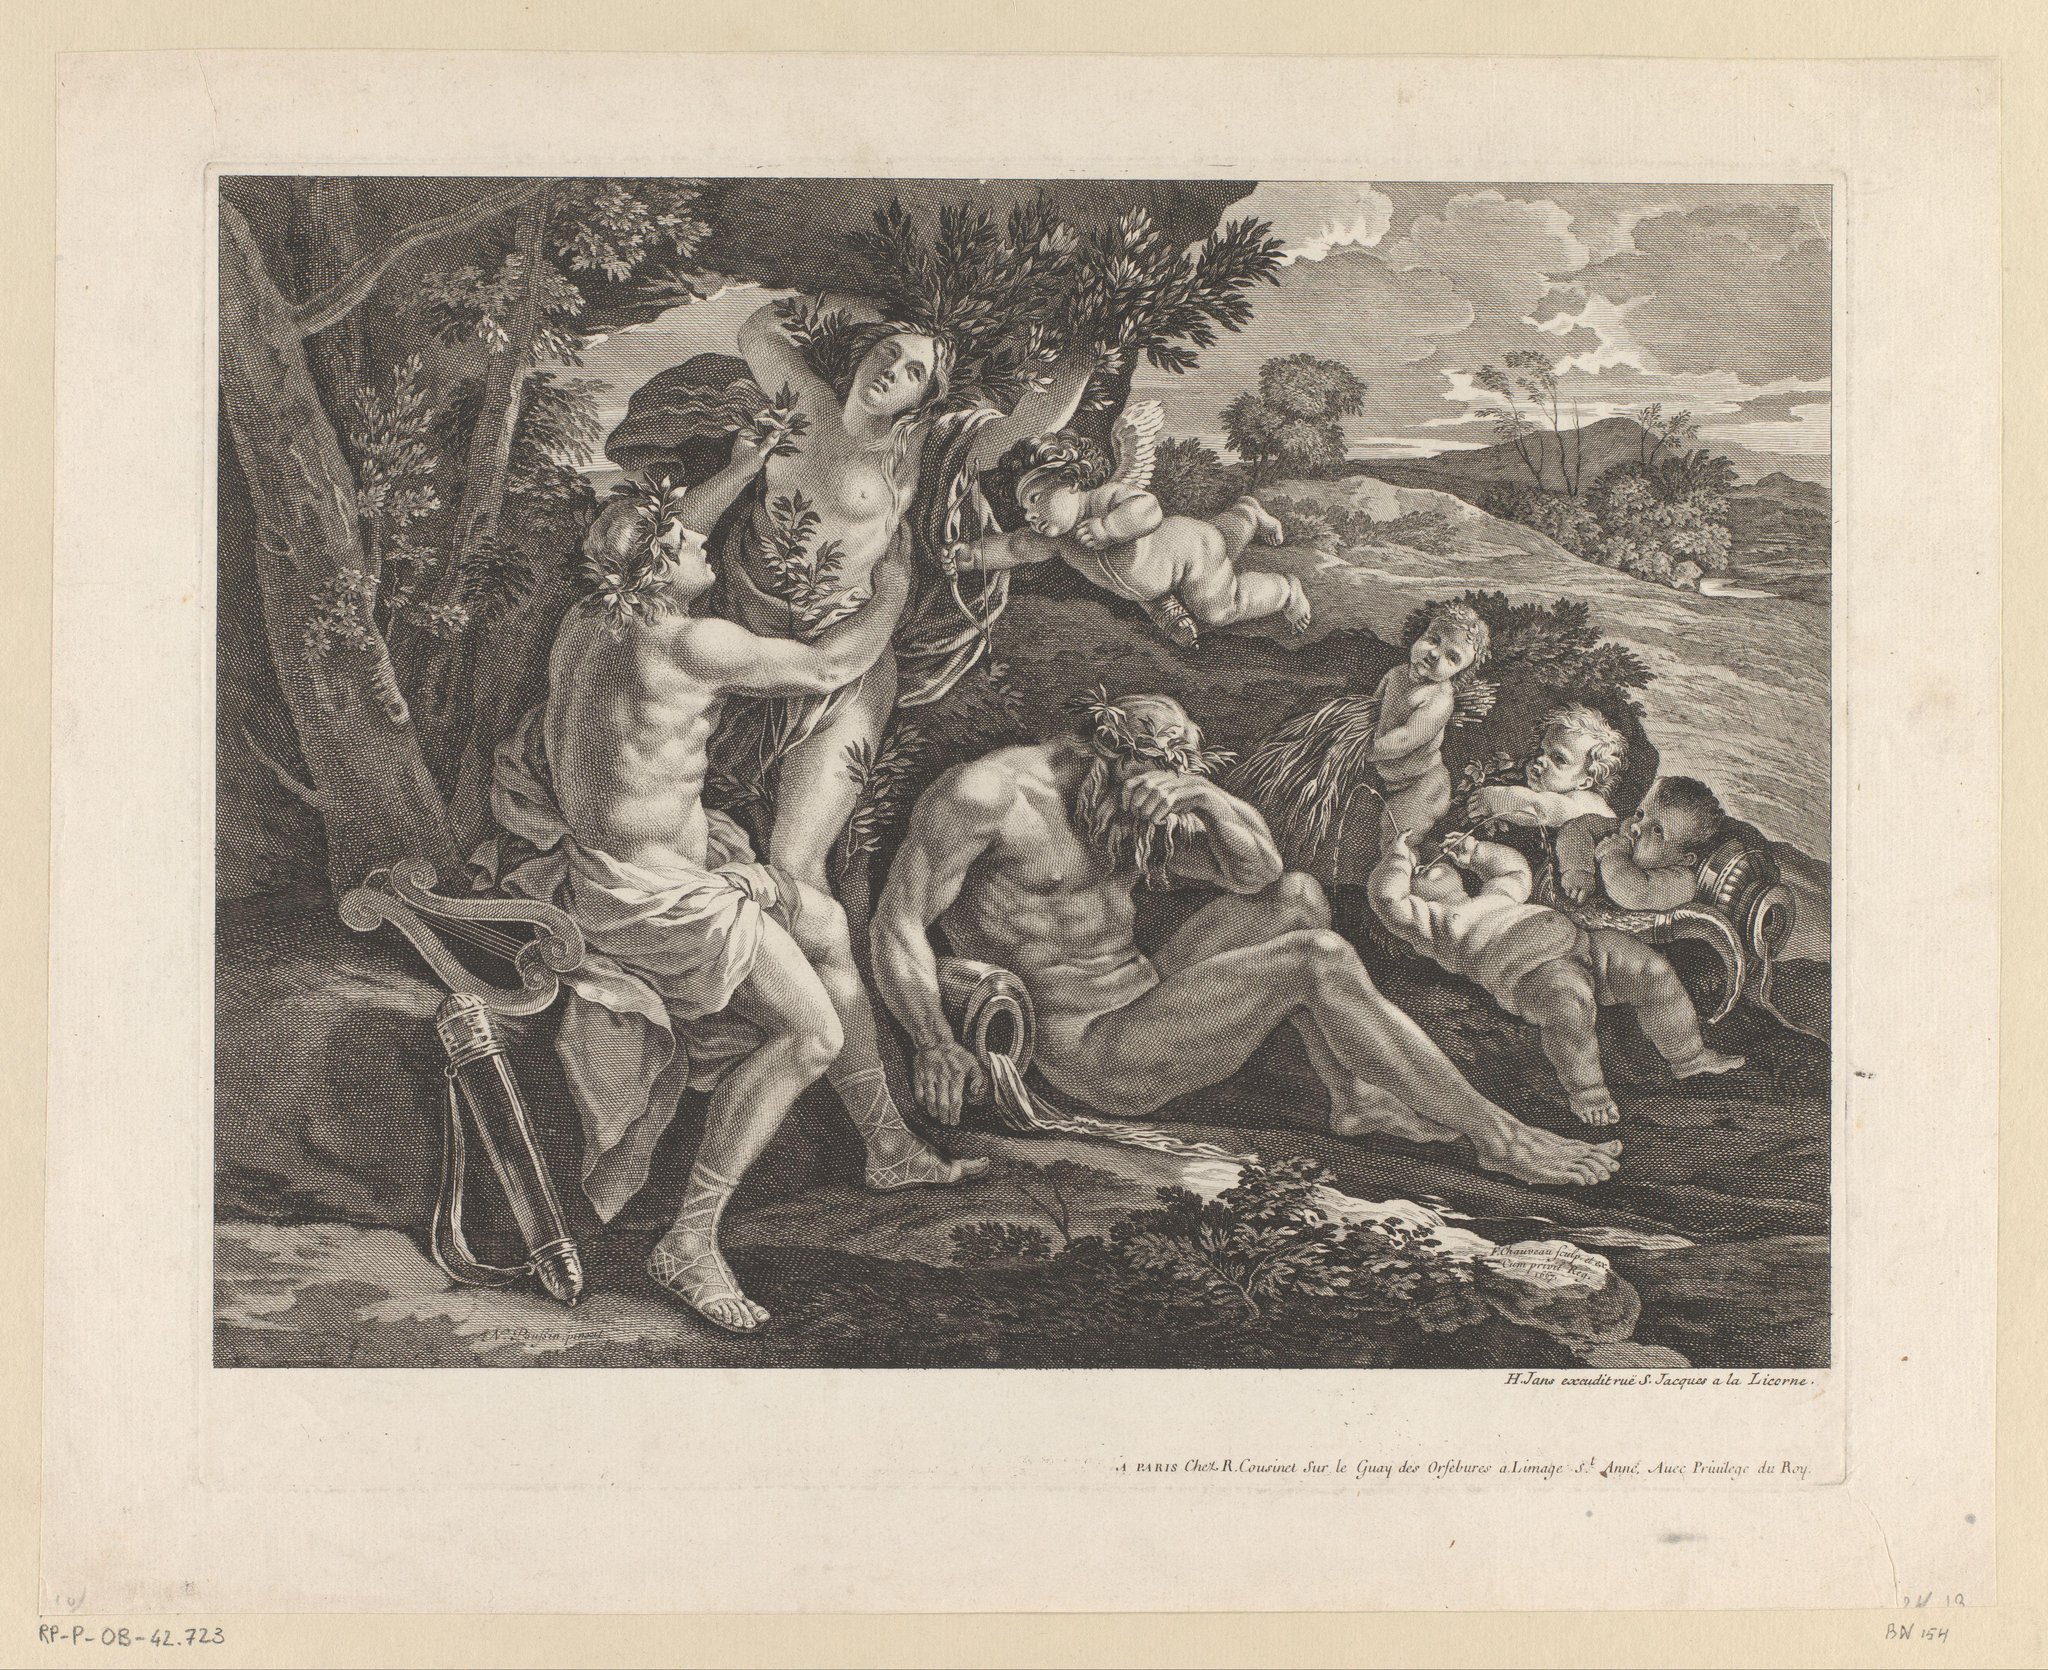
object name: print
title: Apollo en Daphne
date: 1667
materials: paper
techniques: engraving, etching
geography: paris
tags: cupids: 'amores', 'amoretti', 'putti', daphne changed into a laurel-tree: while fleeing from apollo, daphne is changed into a laurel-tree by her father peneus (ovid, metamorphoses i 548)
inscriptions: collector's mark: Lugt 240